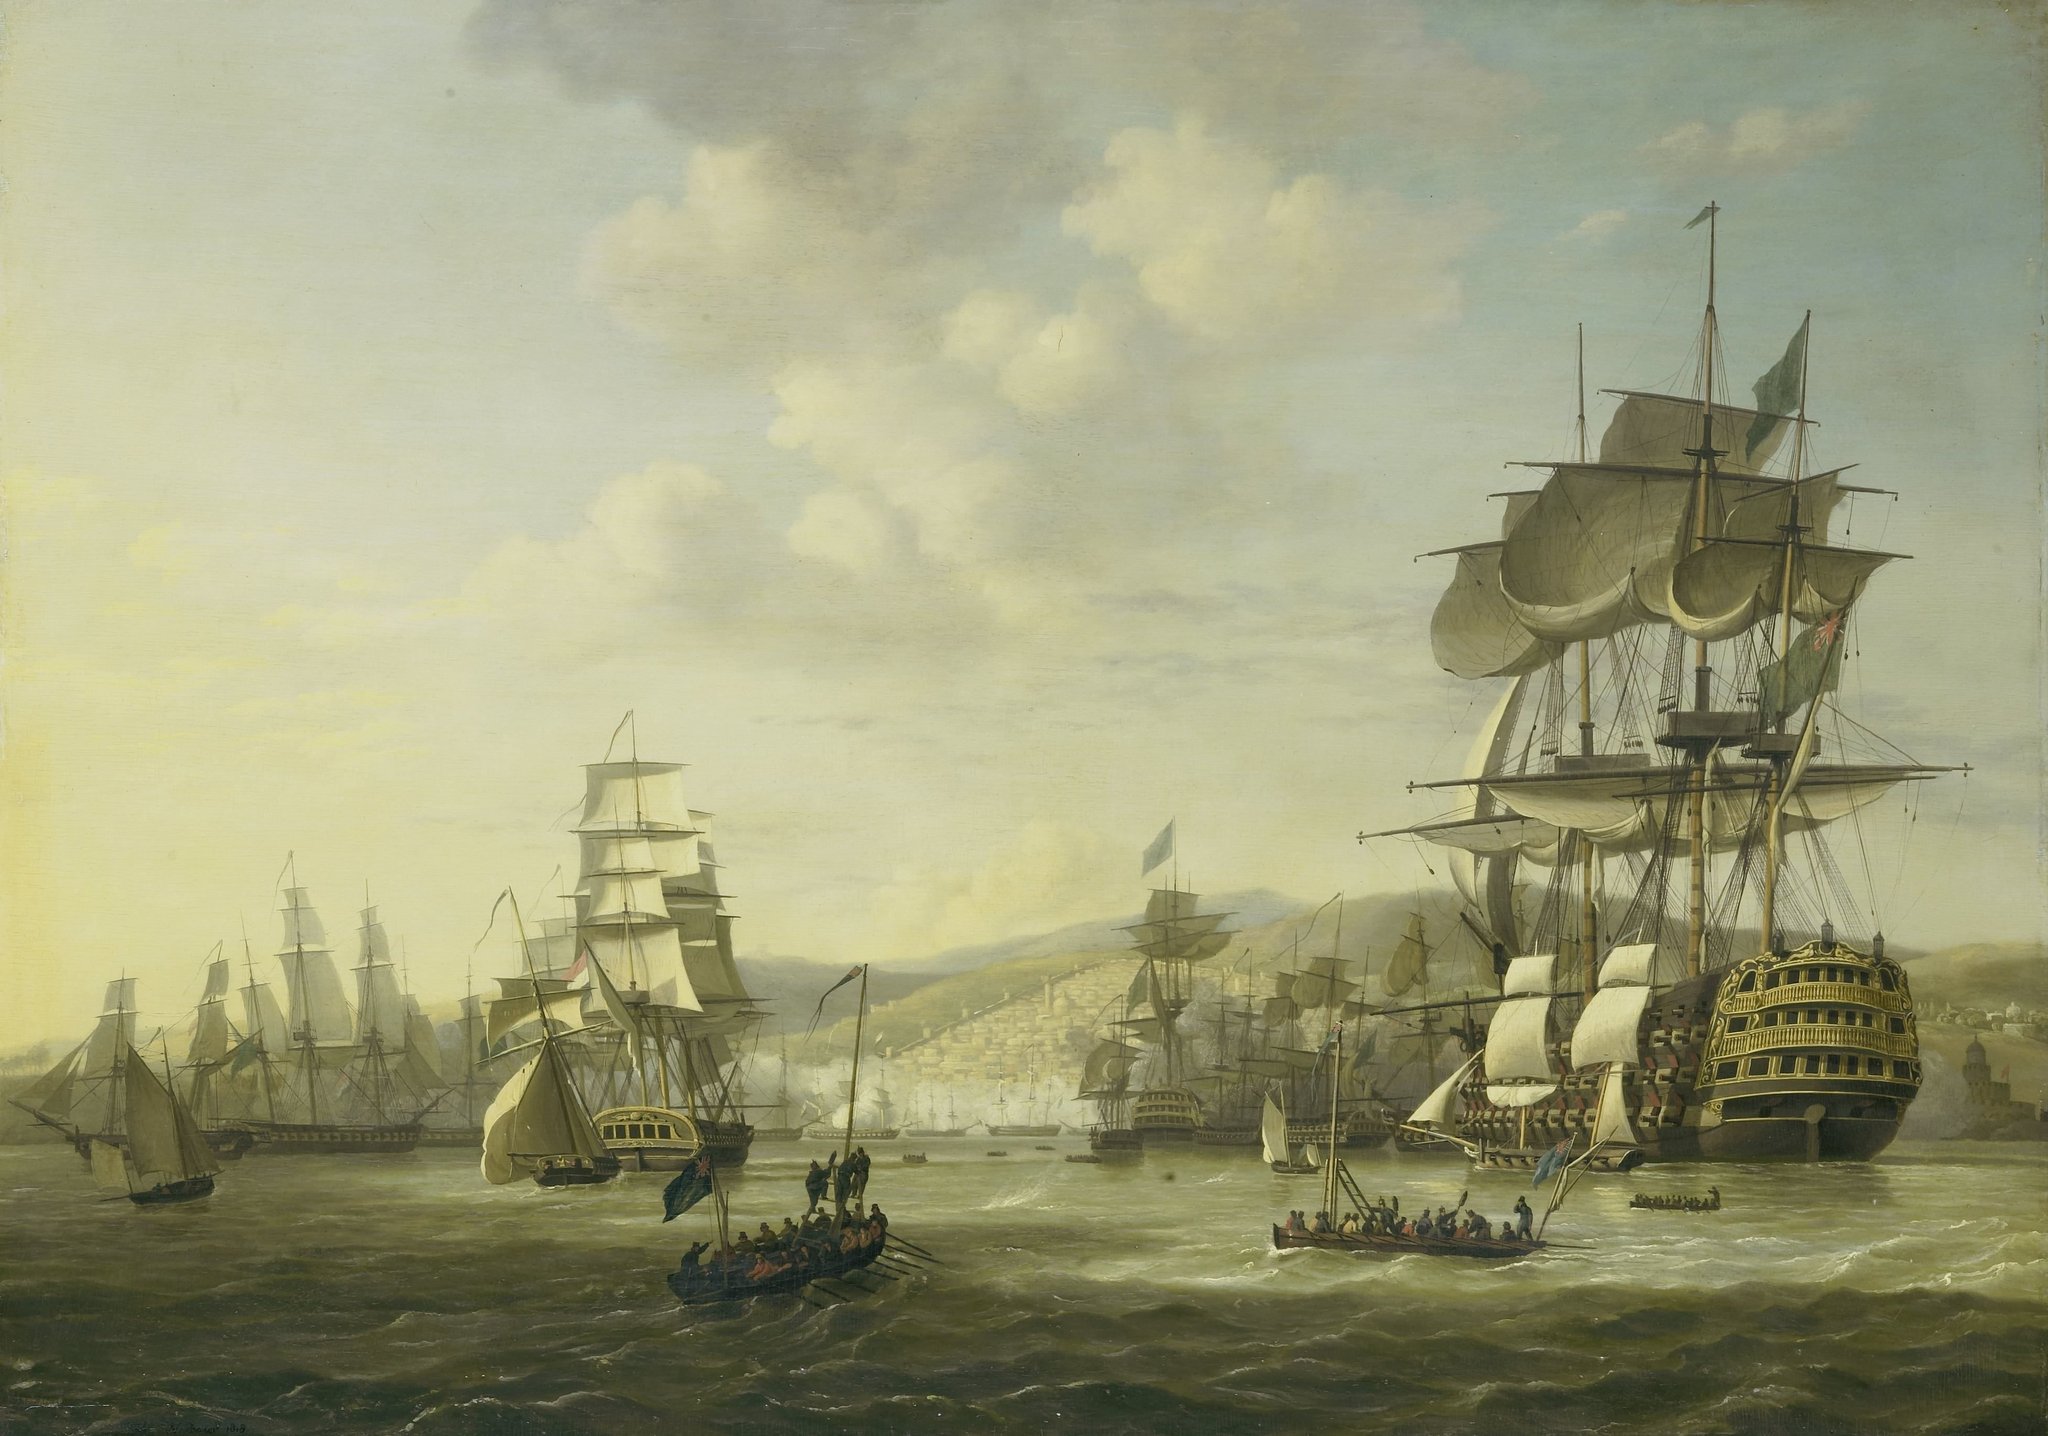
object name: painting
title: Four Episodes during the Presence of the Anglo-Dutch Fleet in the Bay of Algiers, 26 to 27 August 1816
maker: nicolaas baur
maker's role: draughtsman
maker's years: 1767-1820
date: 1818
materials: oil, panel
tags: sailing-ship, sailing-boat, navy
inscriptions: signature and date: ‘N. Baur 1818’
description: De Engels-Nederlandse vloot in de Baai van Algiers ter ondersteuning van het ultimatum tot vrijlating van Europese slaafgemaakte mannen in Noord-Afrika, dergelijke slaafgemaakten stonden bekend als 'christenslaven', 26 augustus 1816. Rechts een groot oorlogsschip, vooraan enige sloepen.